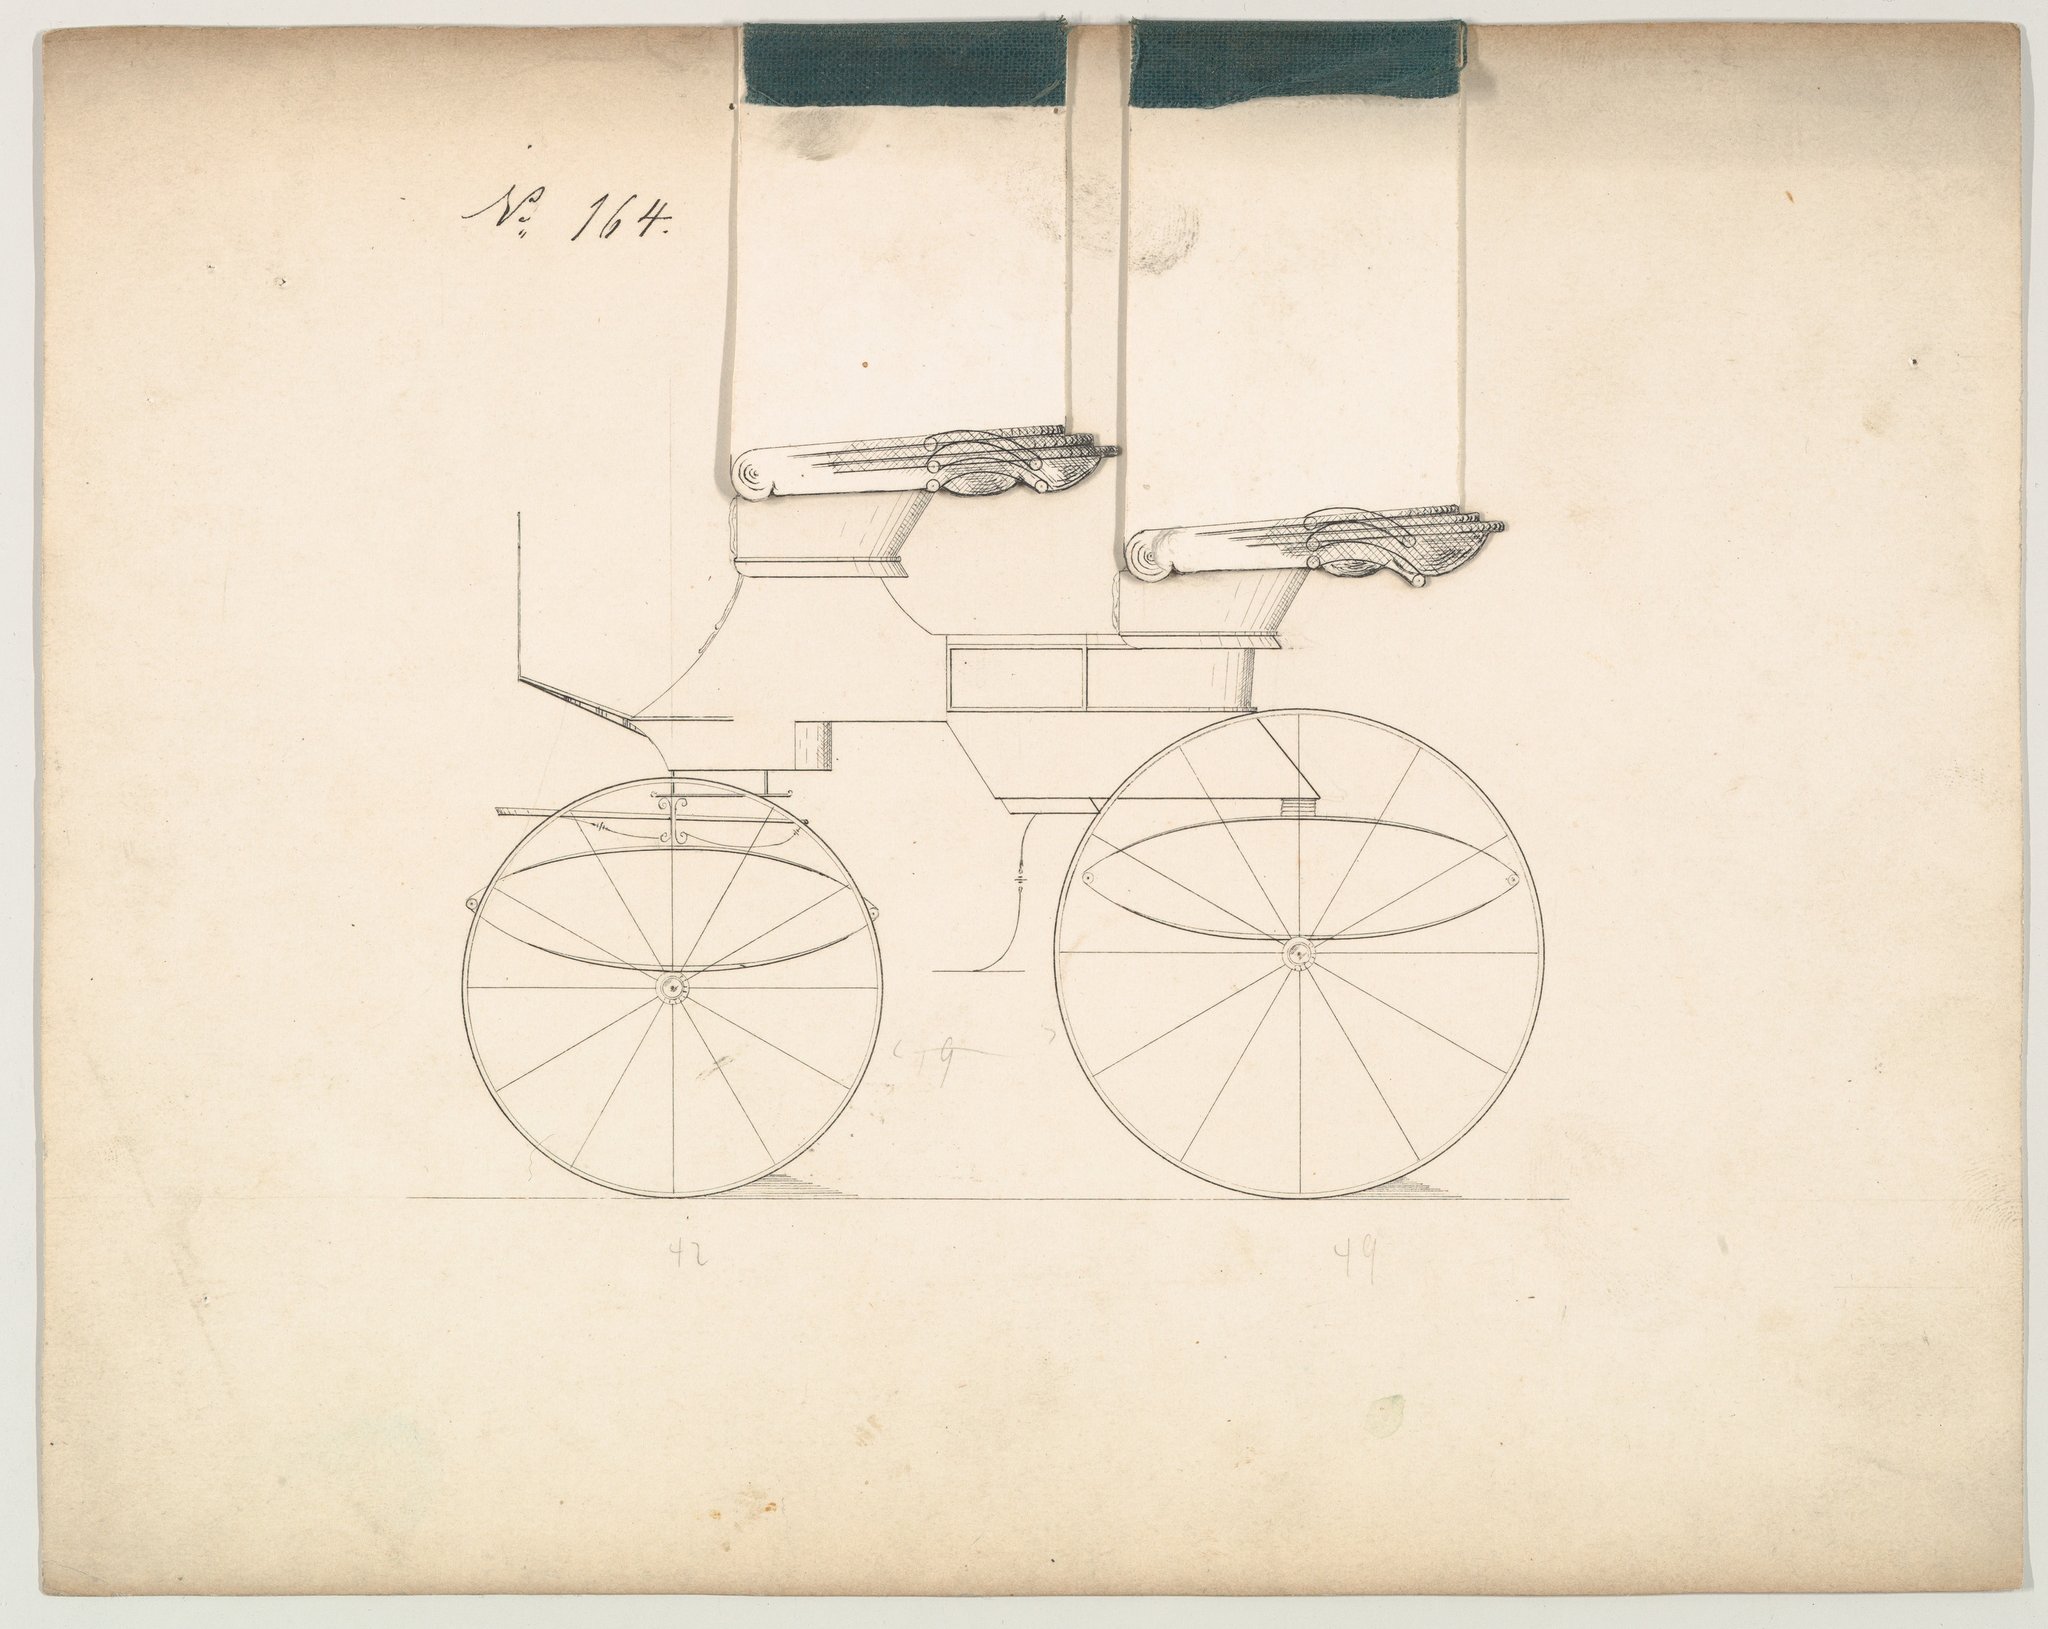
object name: drawing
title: Design for Phaeton, no. 164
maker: brewster & co.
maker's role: manufacturer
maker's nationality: american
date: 1850-1874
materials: ink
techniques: pen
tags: carriages